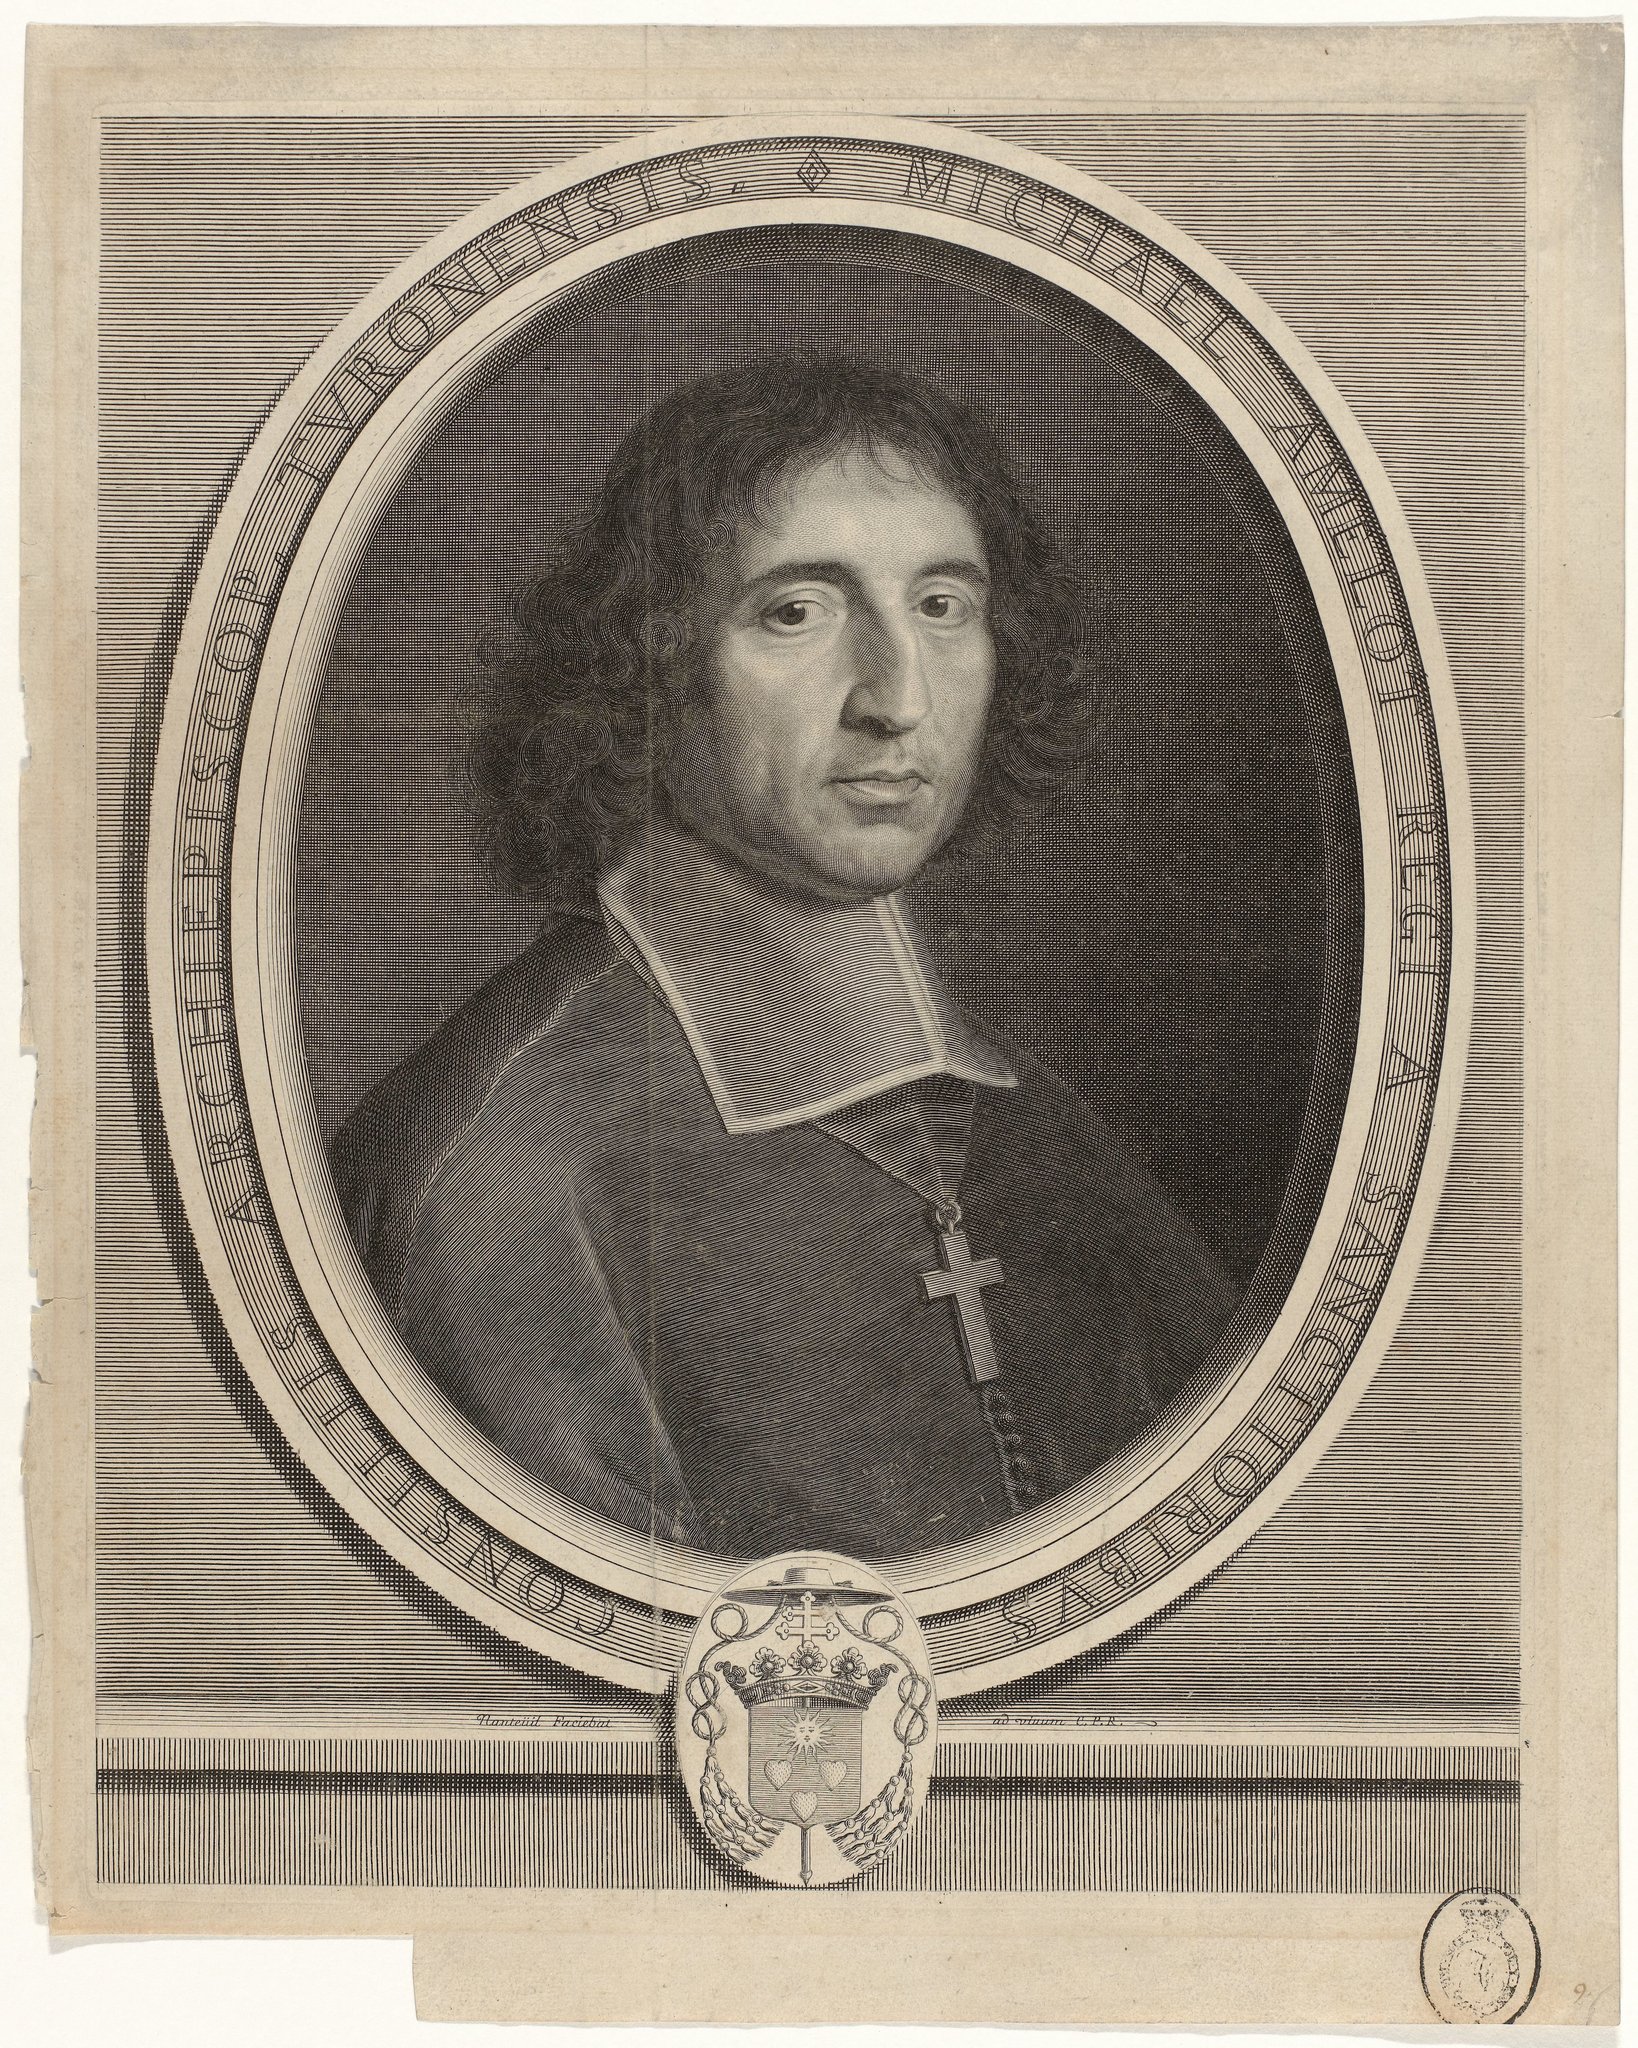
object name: print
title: Portret Michel Amelot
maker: robert nanteuil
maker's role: print maker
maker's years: 1623-1678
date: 1675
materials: paper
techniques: engraving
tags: paris, michel amelot de gournay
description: Buste naar rechts, kruis op de borst, in ovale lijst met randschrift. Wapen middenonder.